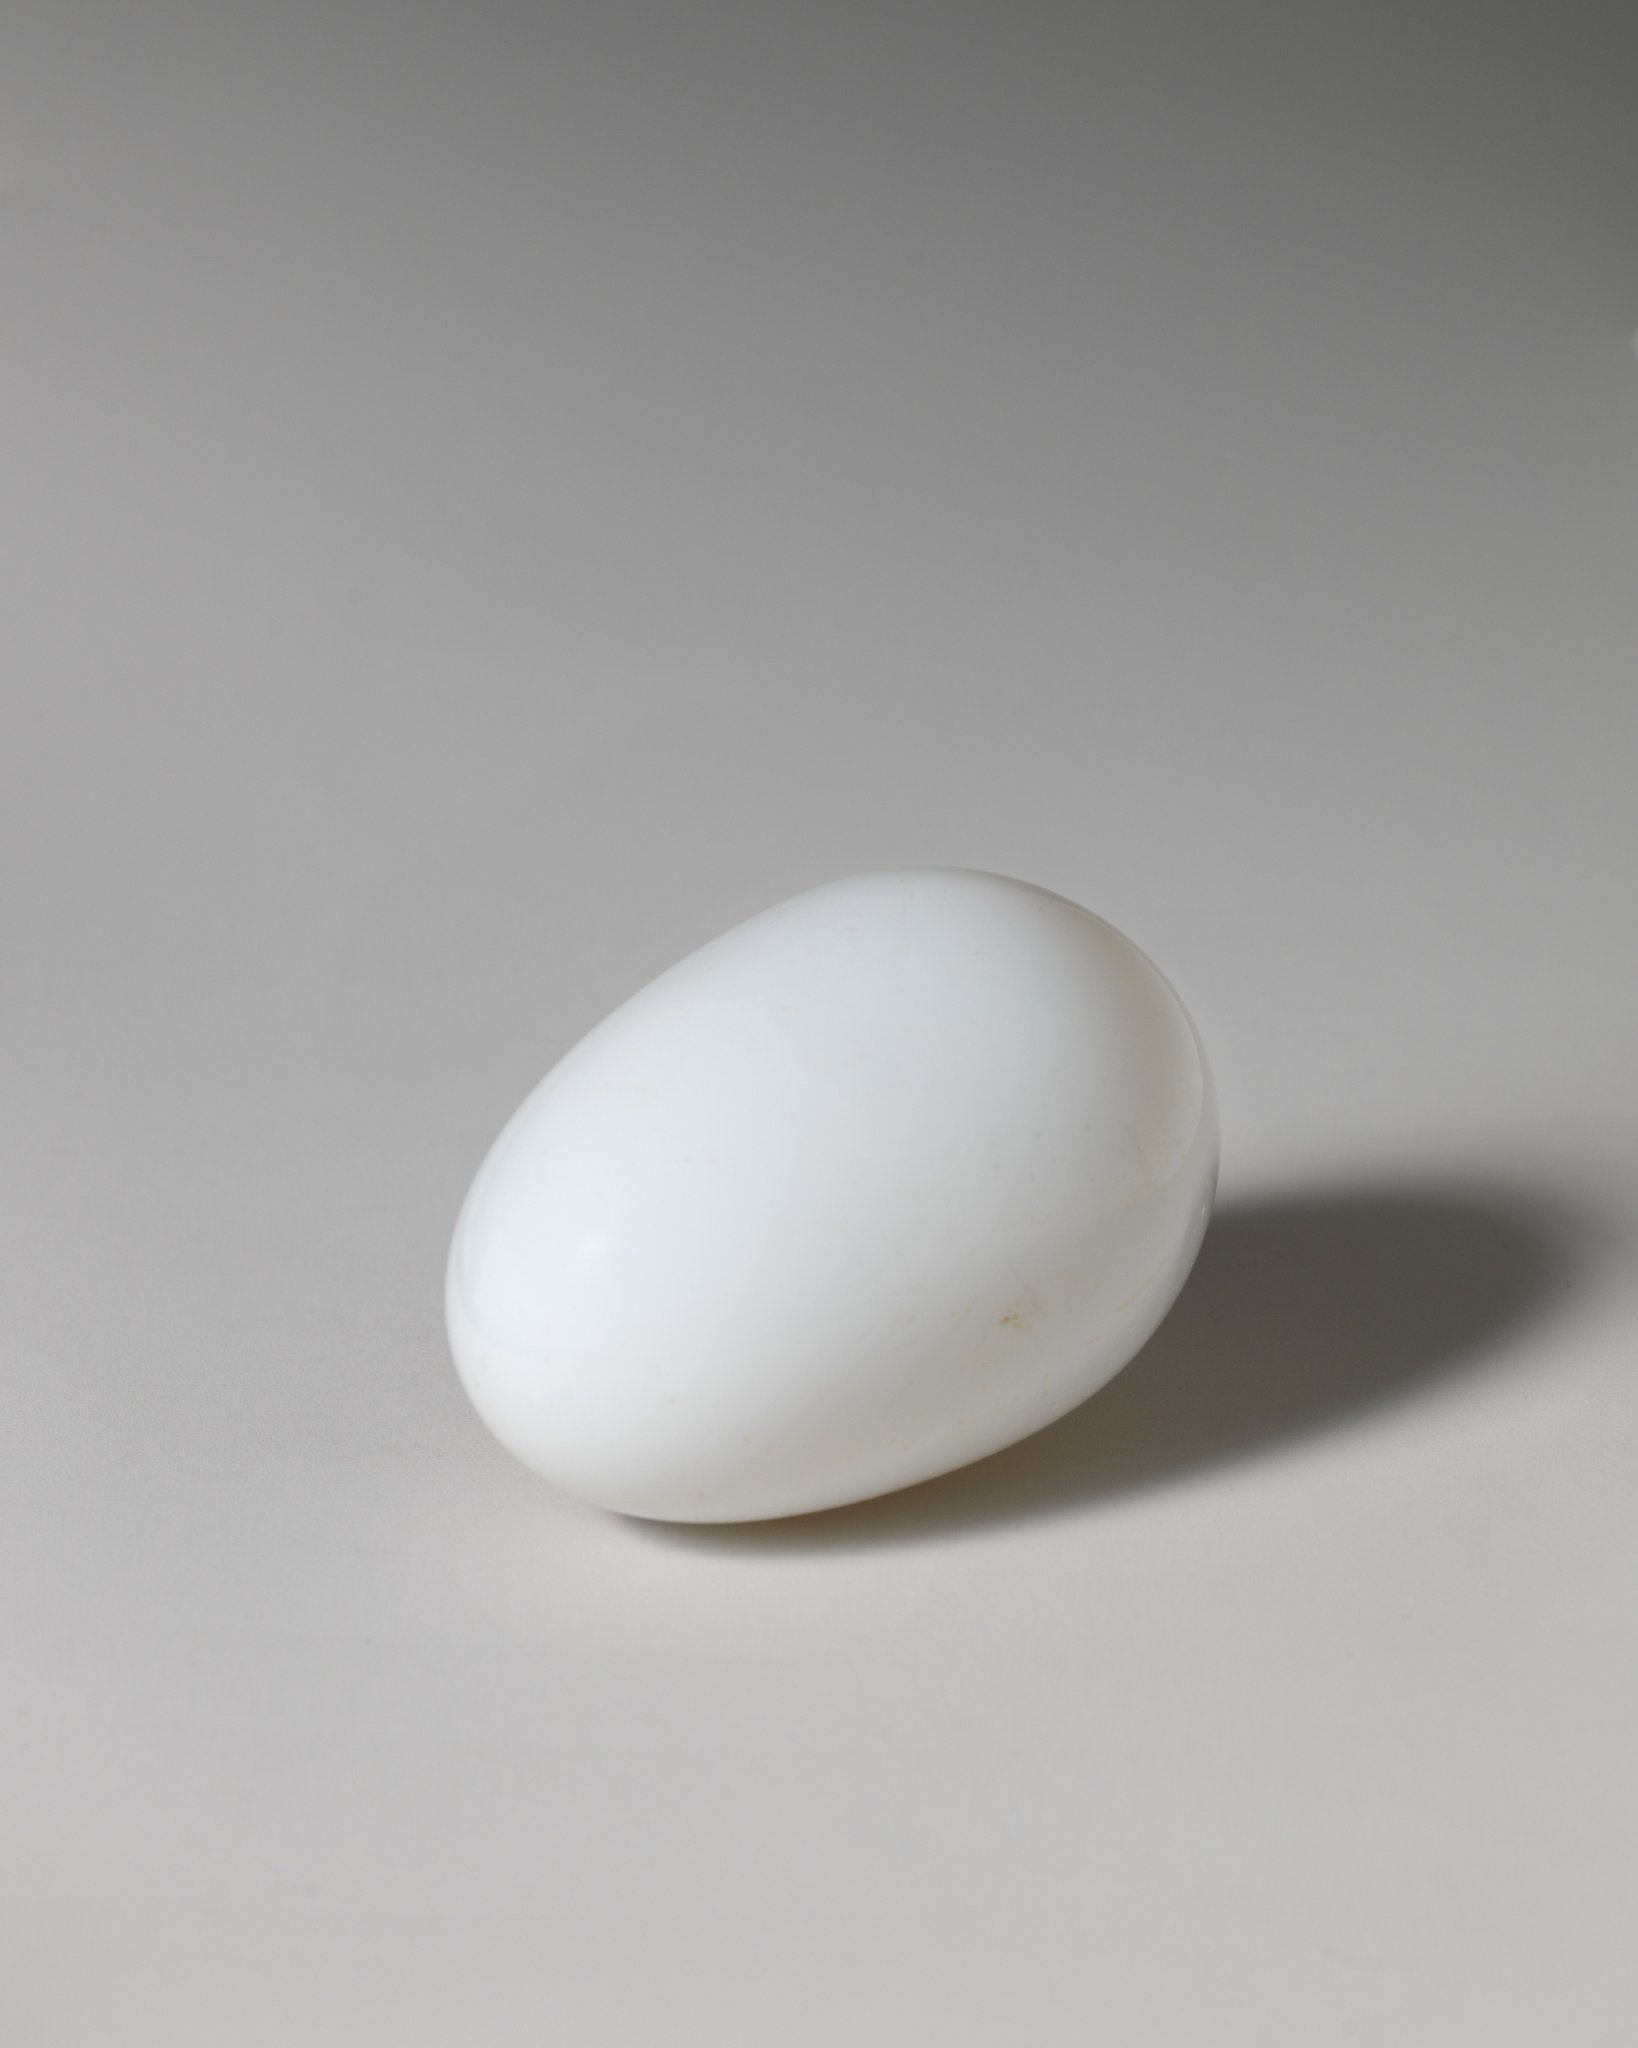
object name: figure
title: Egg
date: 1767-1833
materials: glass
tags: eggs